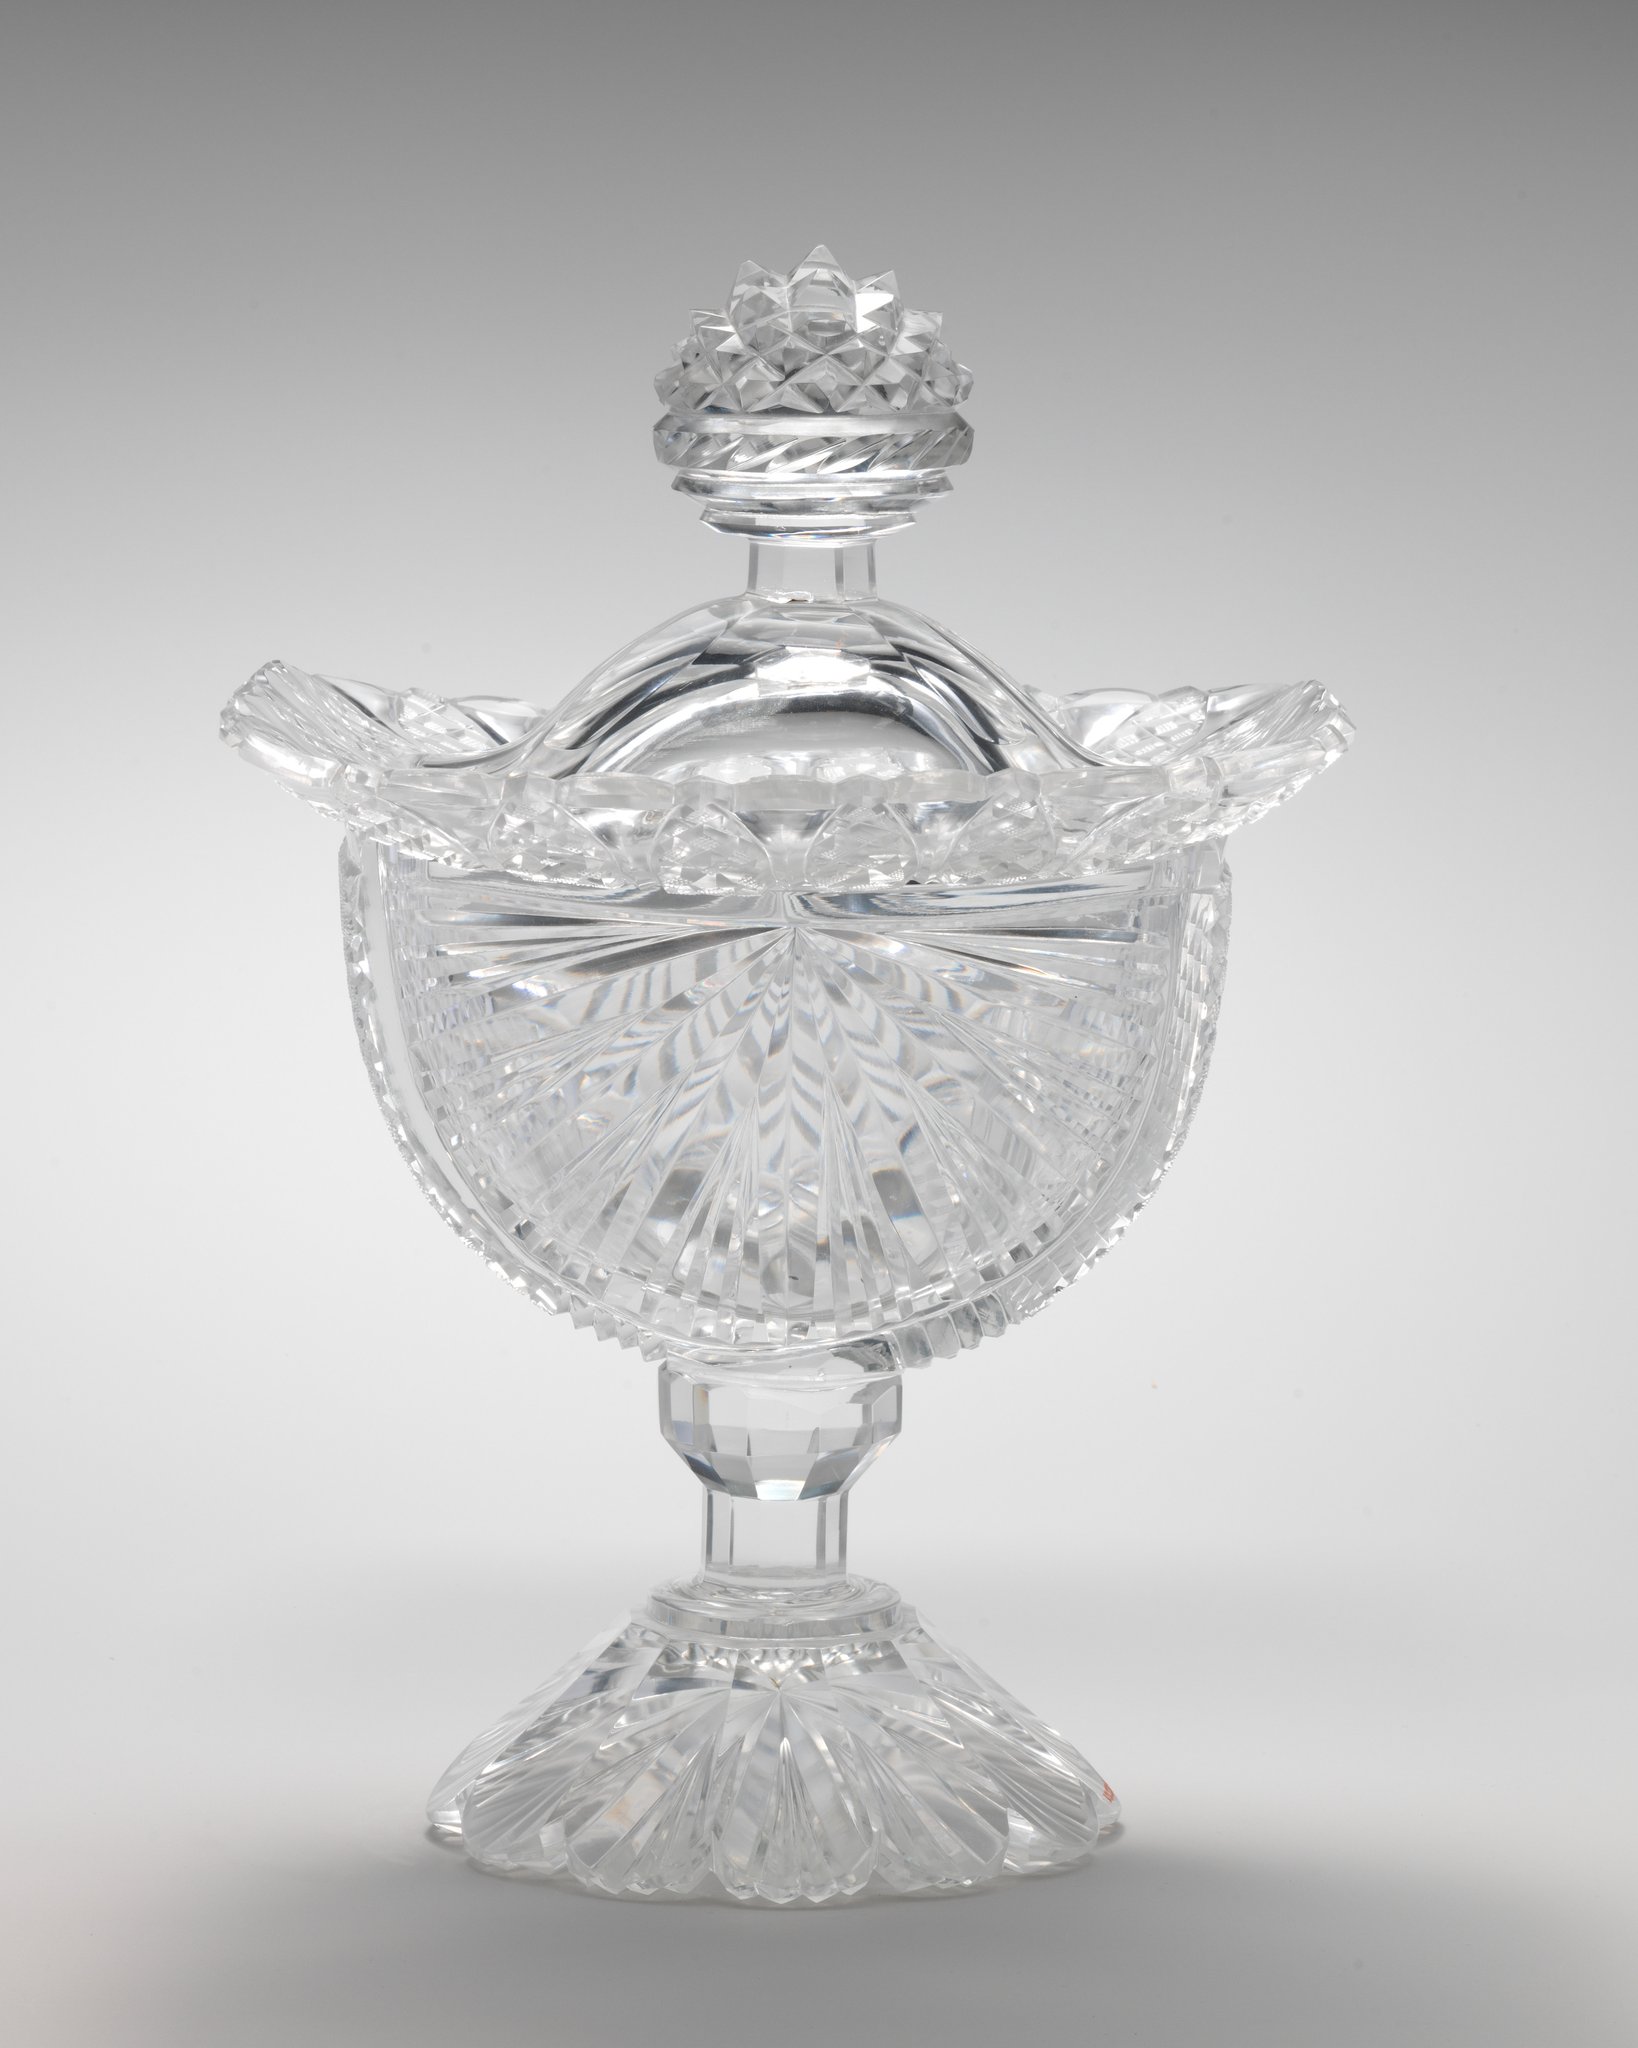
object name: bowl with cover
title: Bowl with cover (one of a pair)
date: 1801-1900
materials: glass